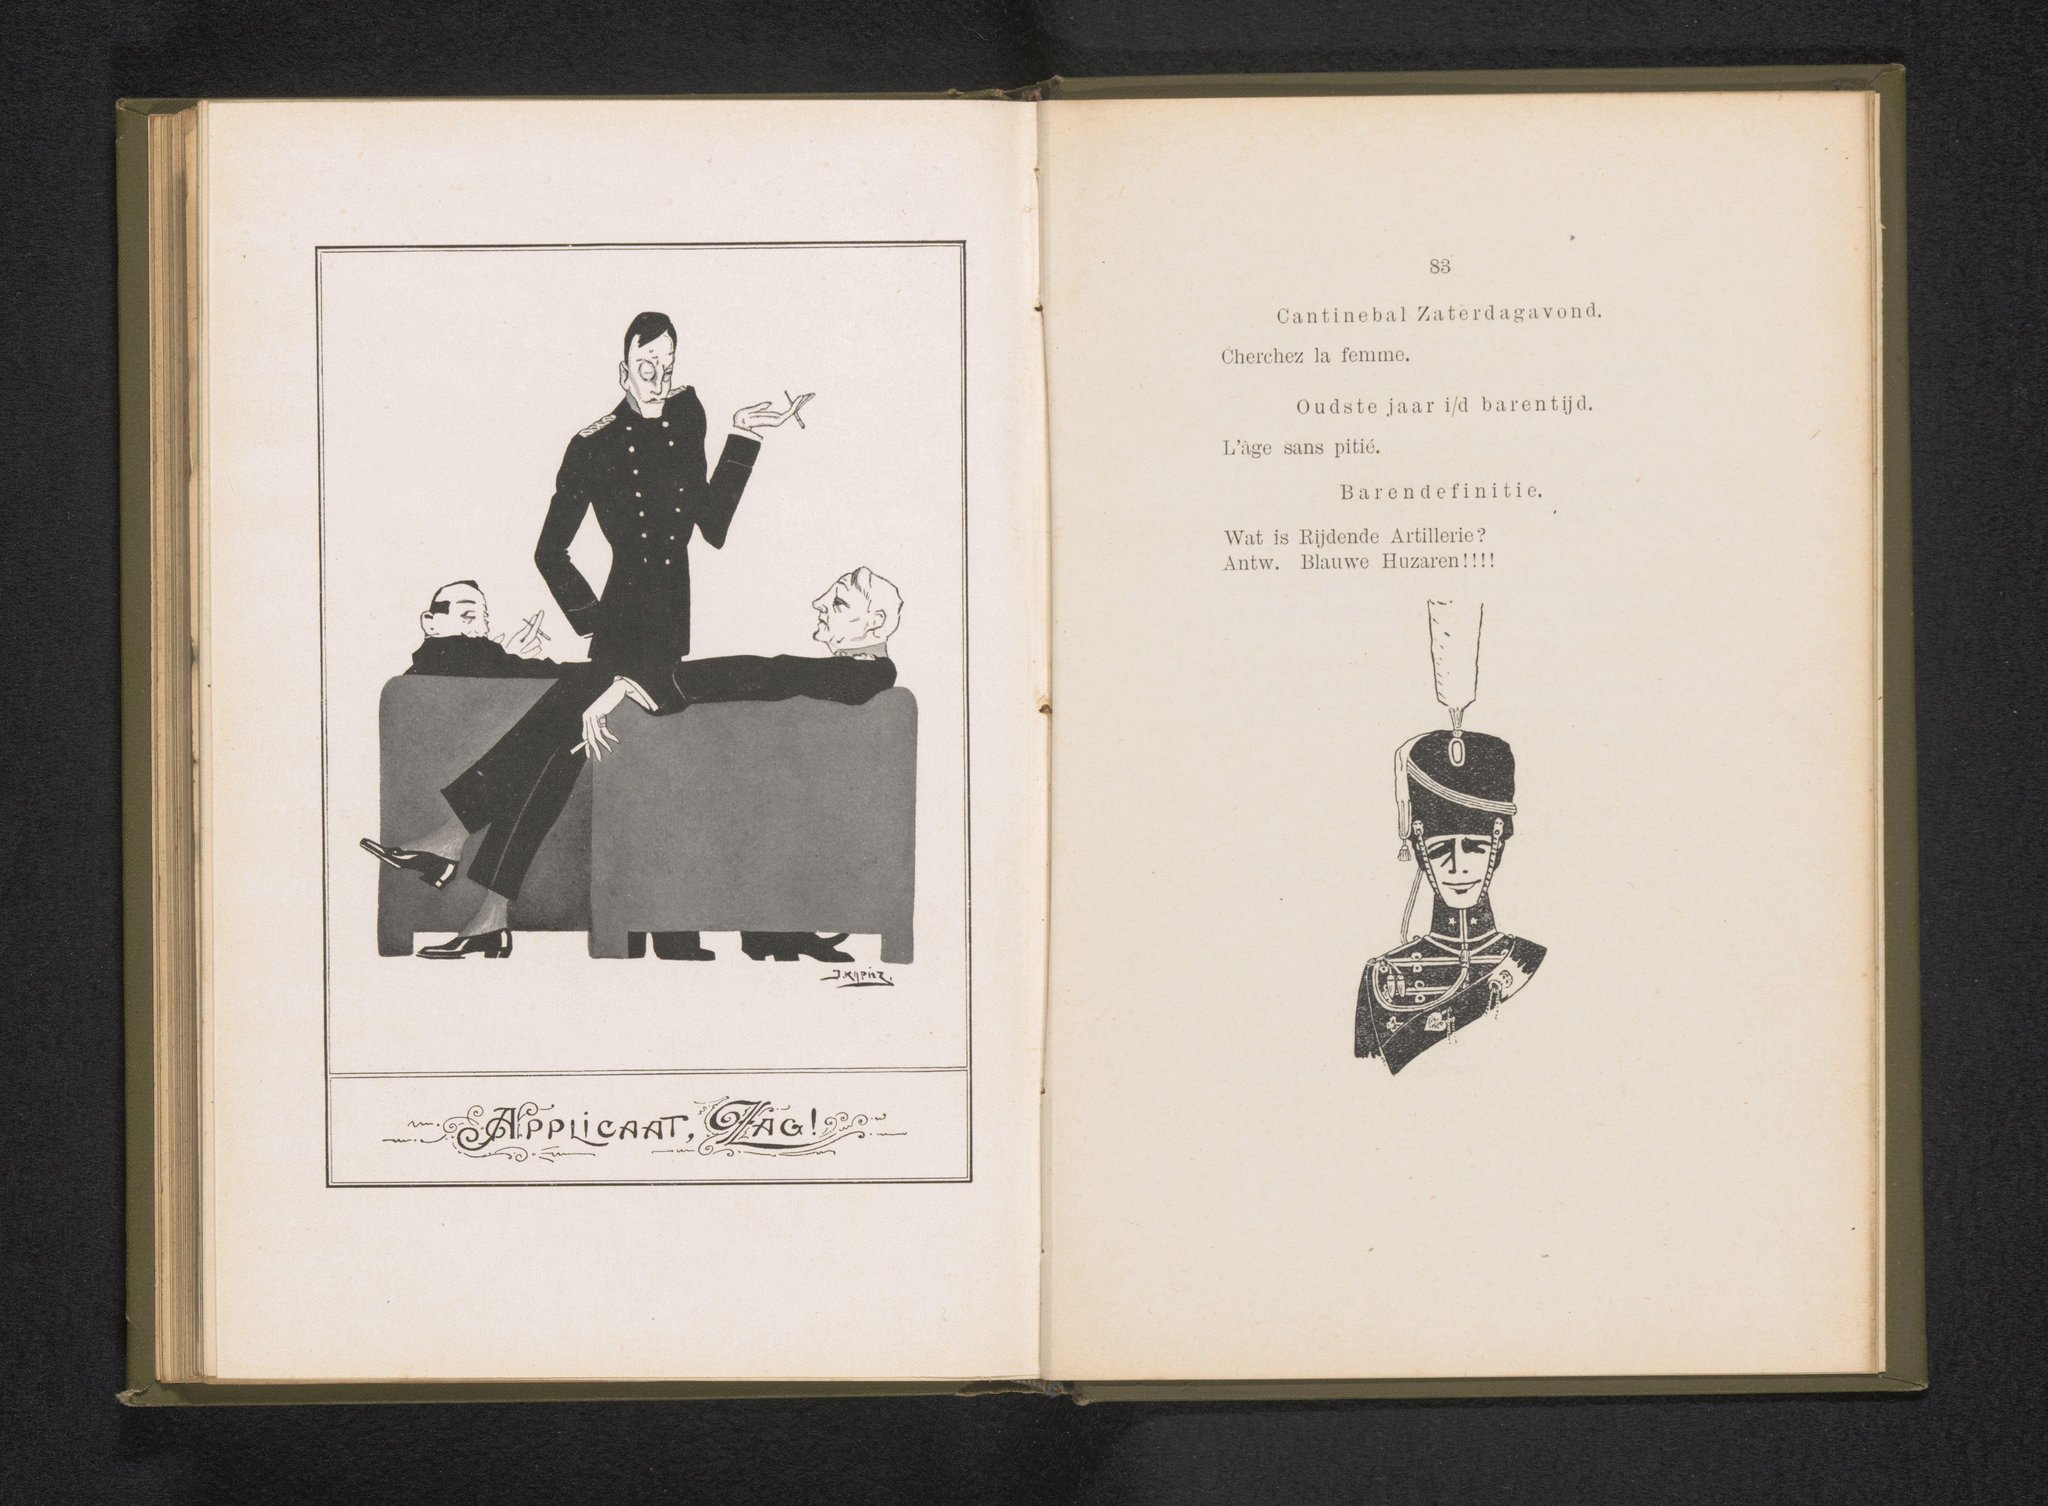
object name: photomechanical print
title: Applicaat, Hag!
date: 1911-1916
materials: paper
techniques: autotype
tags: mischief-making play, adult man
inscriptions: name: ‘J. KAPI[.]Z’